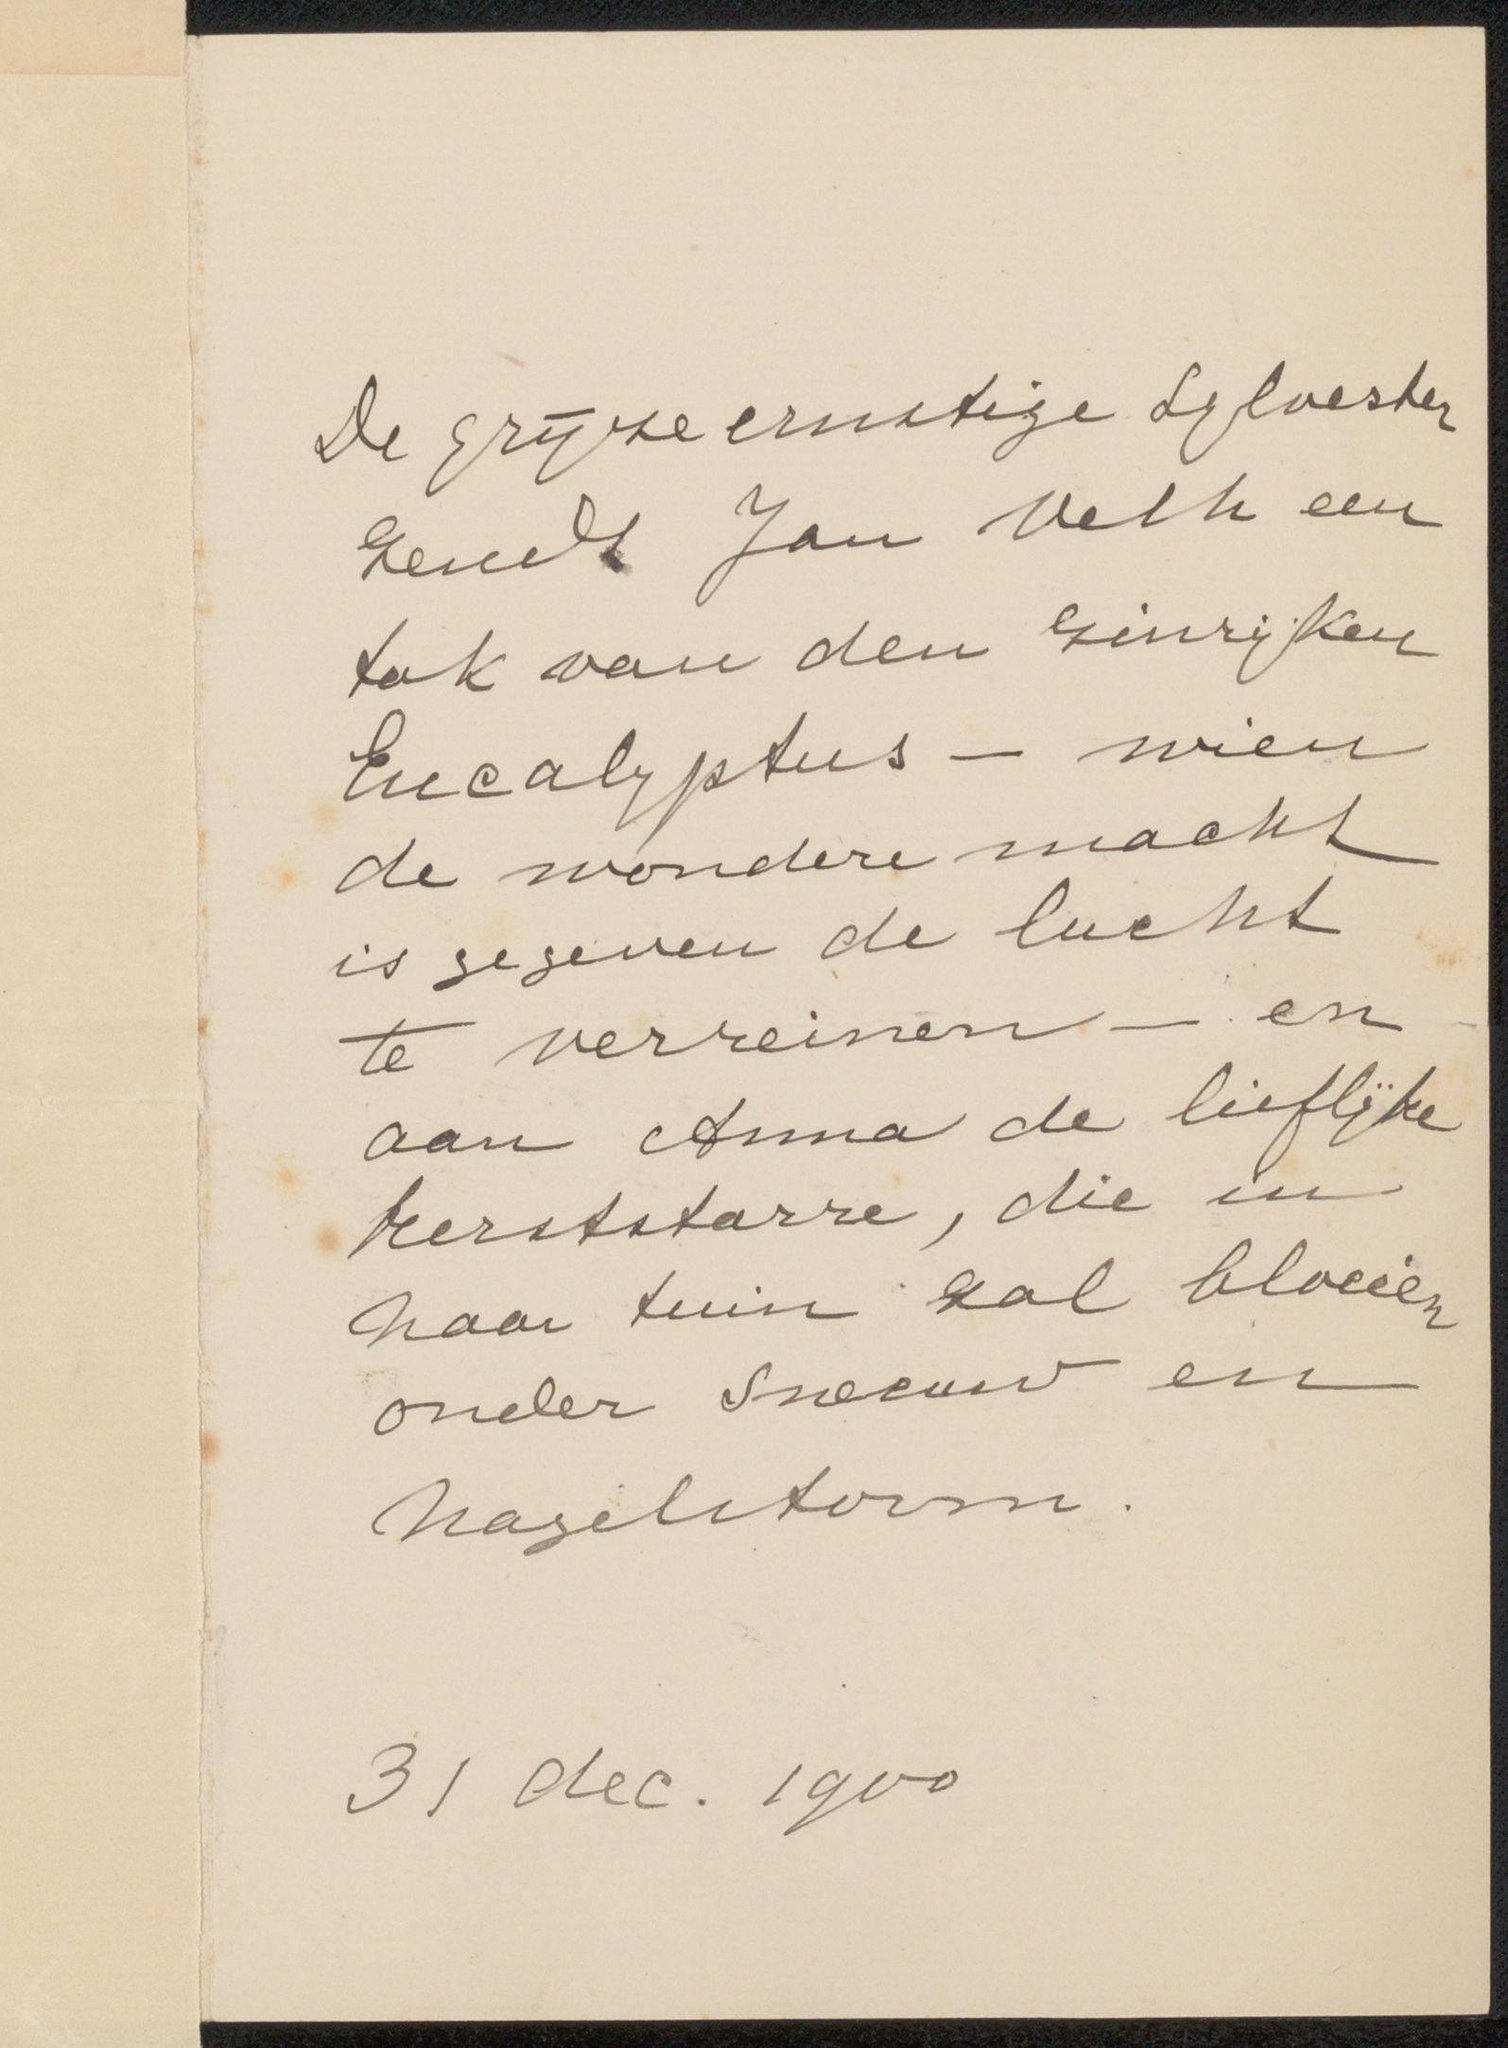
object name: letter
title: Brief aan Jan Veth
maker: etha fles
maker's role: print maker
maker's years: 1857-1948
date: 1900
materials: ink, paper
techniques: pen, writing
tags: dordrecht, amsterdam, painter, draughtsman, designer, jan veth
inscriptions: collector's mark: ‘RPK’